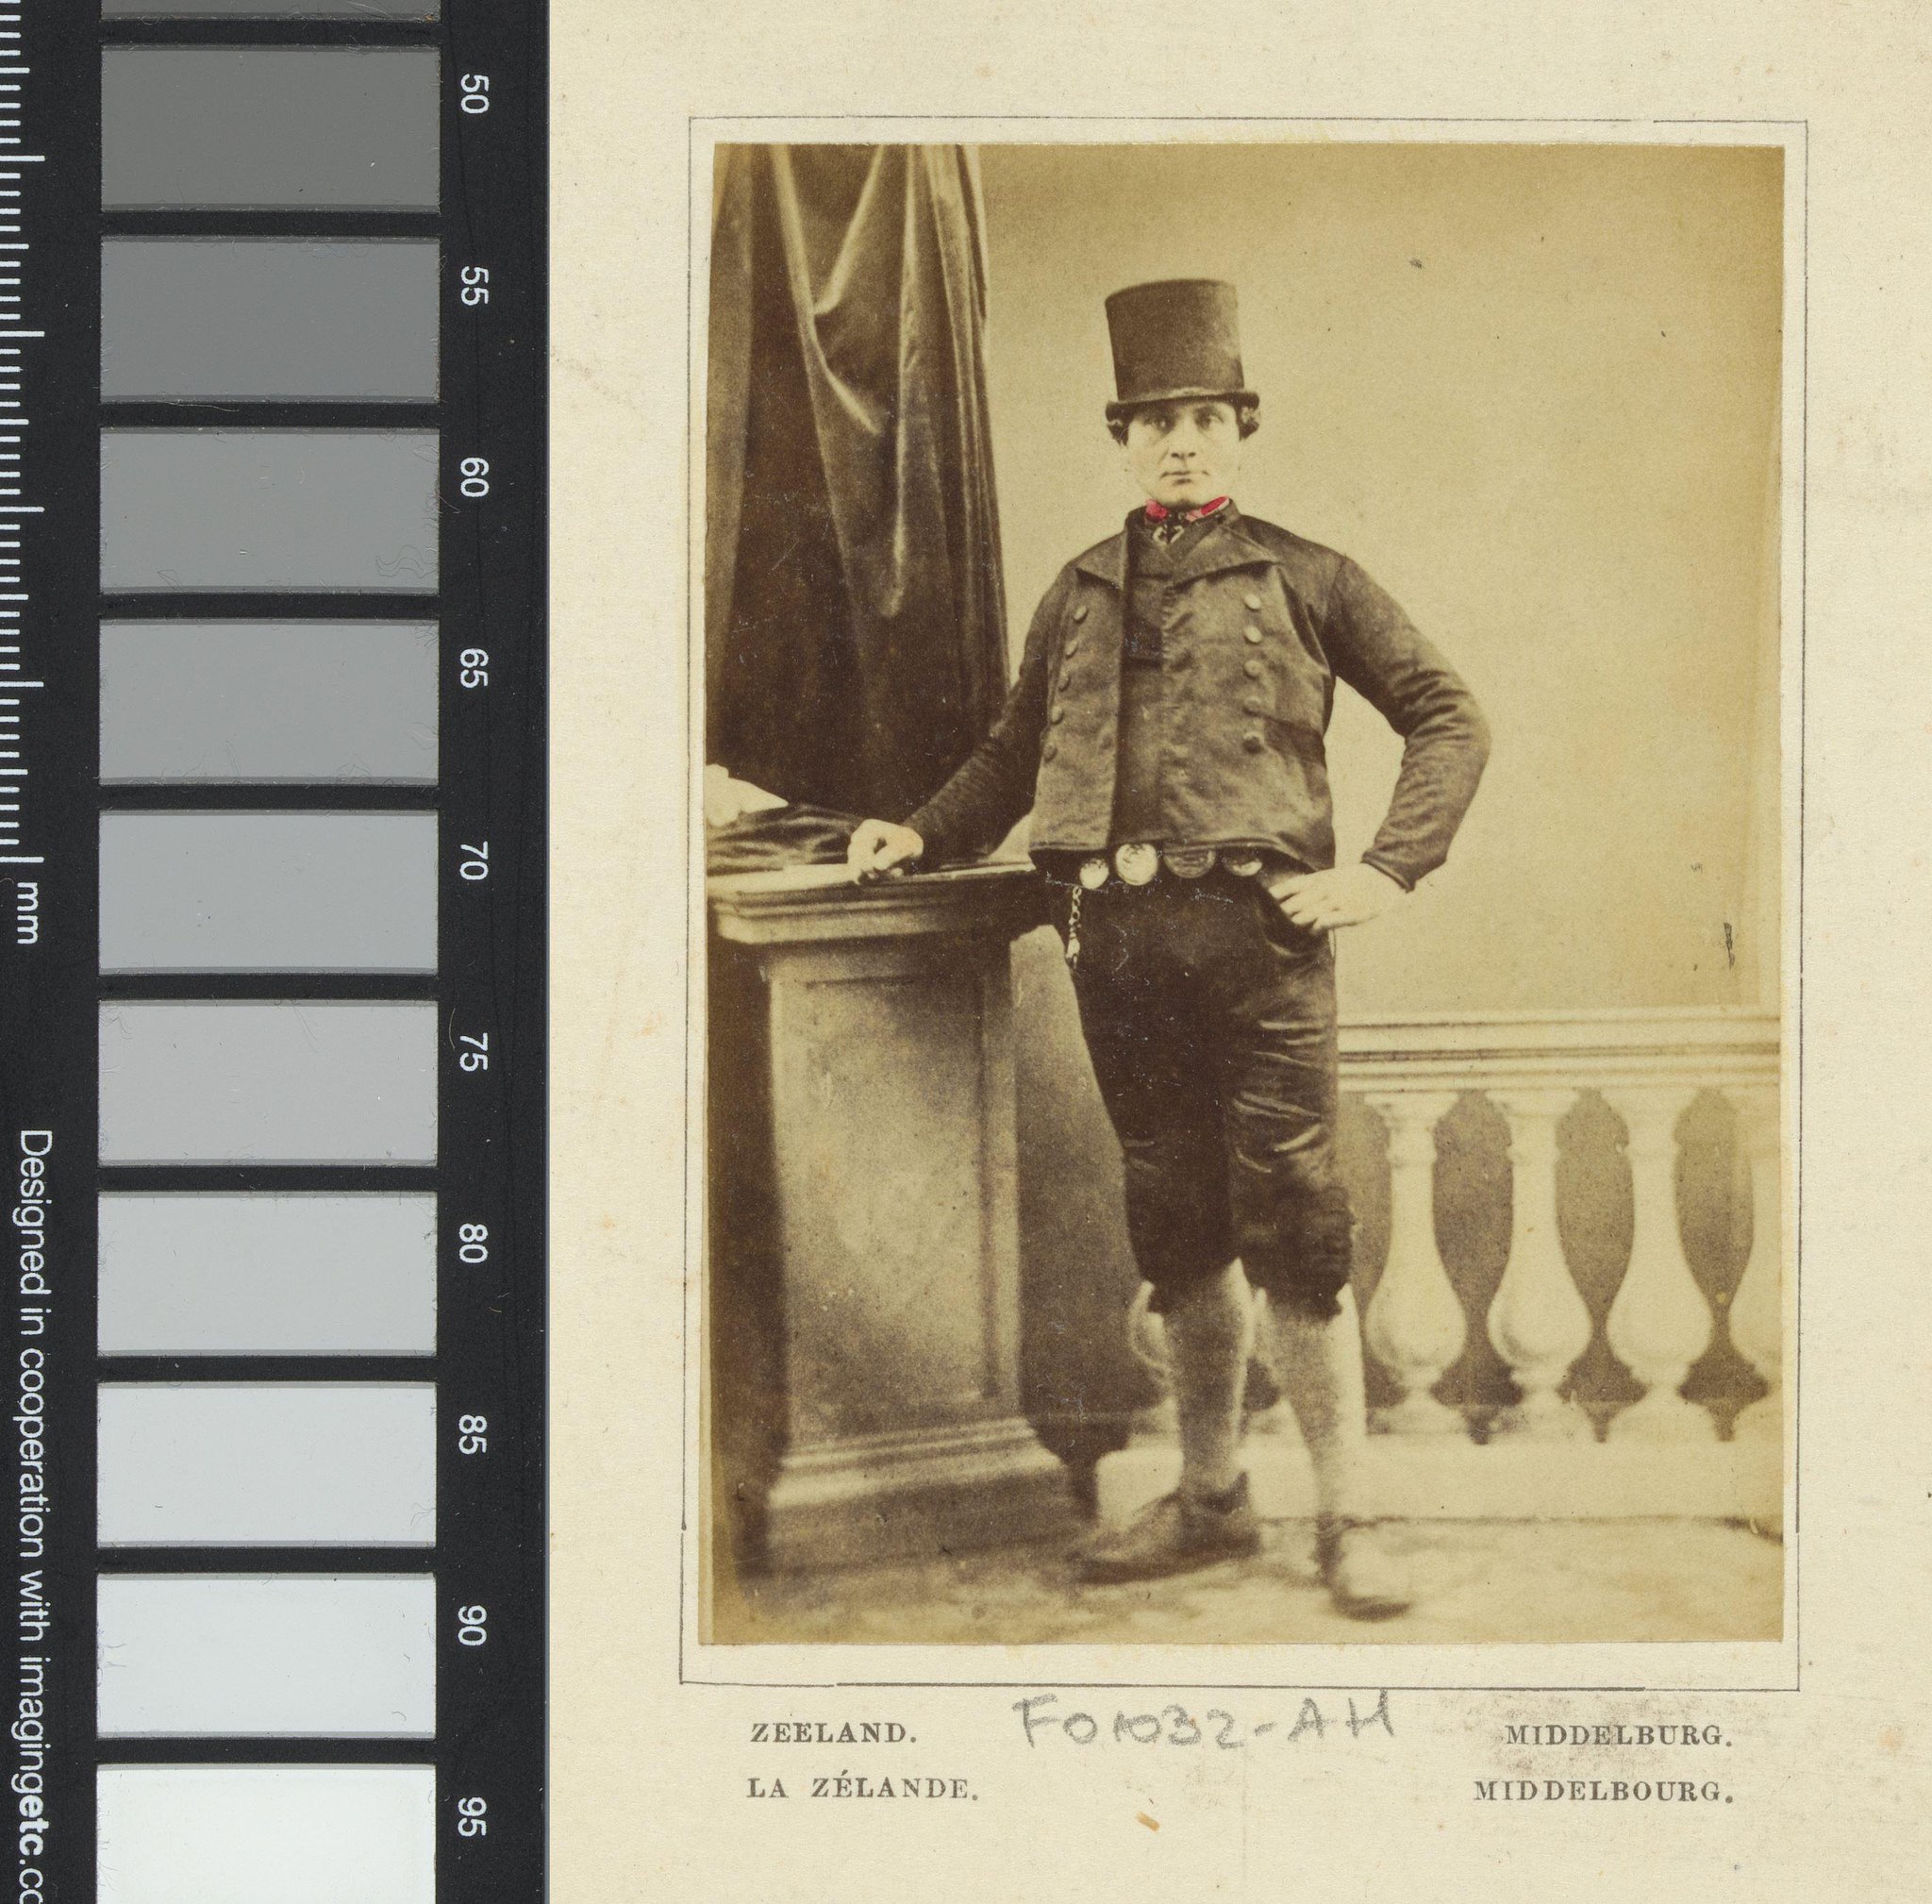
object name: photograph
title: Costumes des Pays-Bas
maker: andries jager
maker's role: publisher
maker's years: 1825-1905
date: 1860-1890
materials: cardboard, photographic support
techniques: albumen print, hand coloring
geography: amsterdam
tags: folk costume, regional costume (+ men's clothes), historical persons, europeans (with name), netherlands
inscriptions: inscription: ‘Uitgave van A. JAGER, Water 110 te Amsterdam.’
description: Deze foto maakt deel uit van een omslag met 48 foto's op 12 bladen.